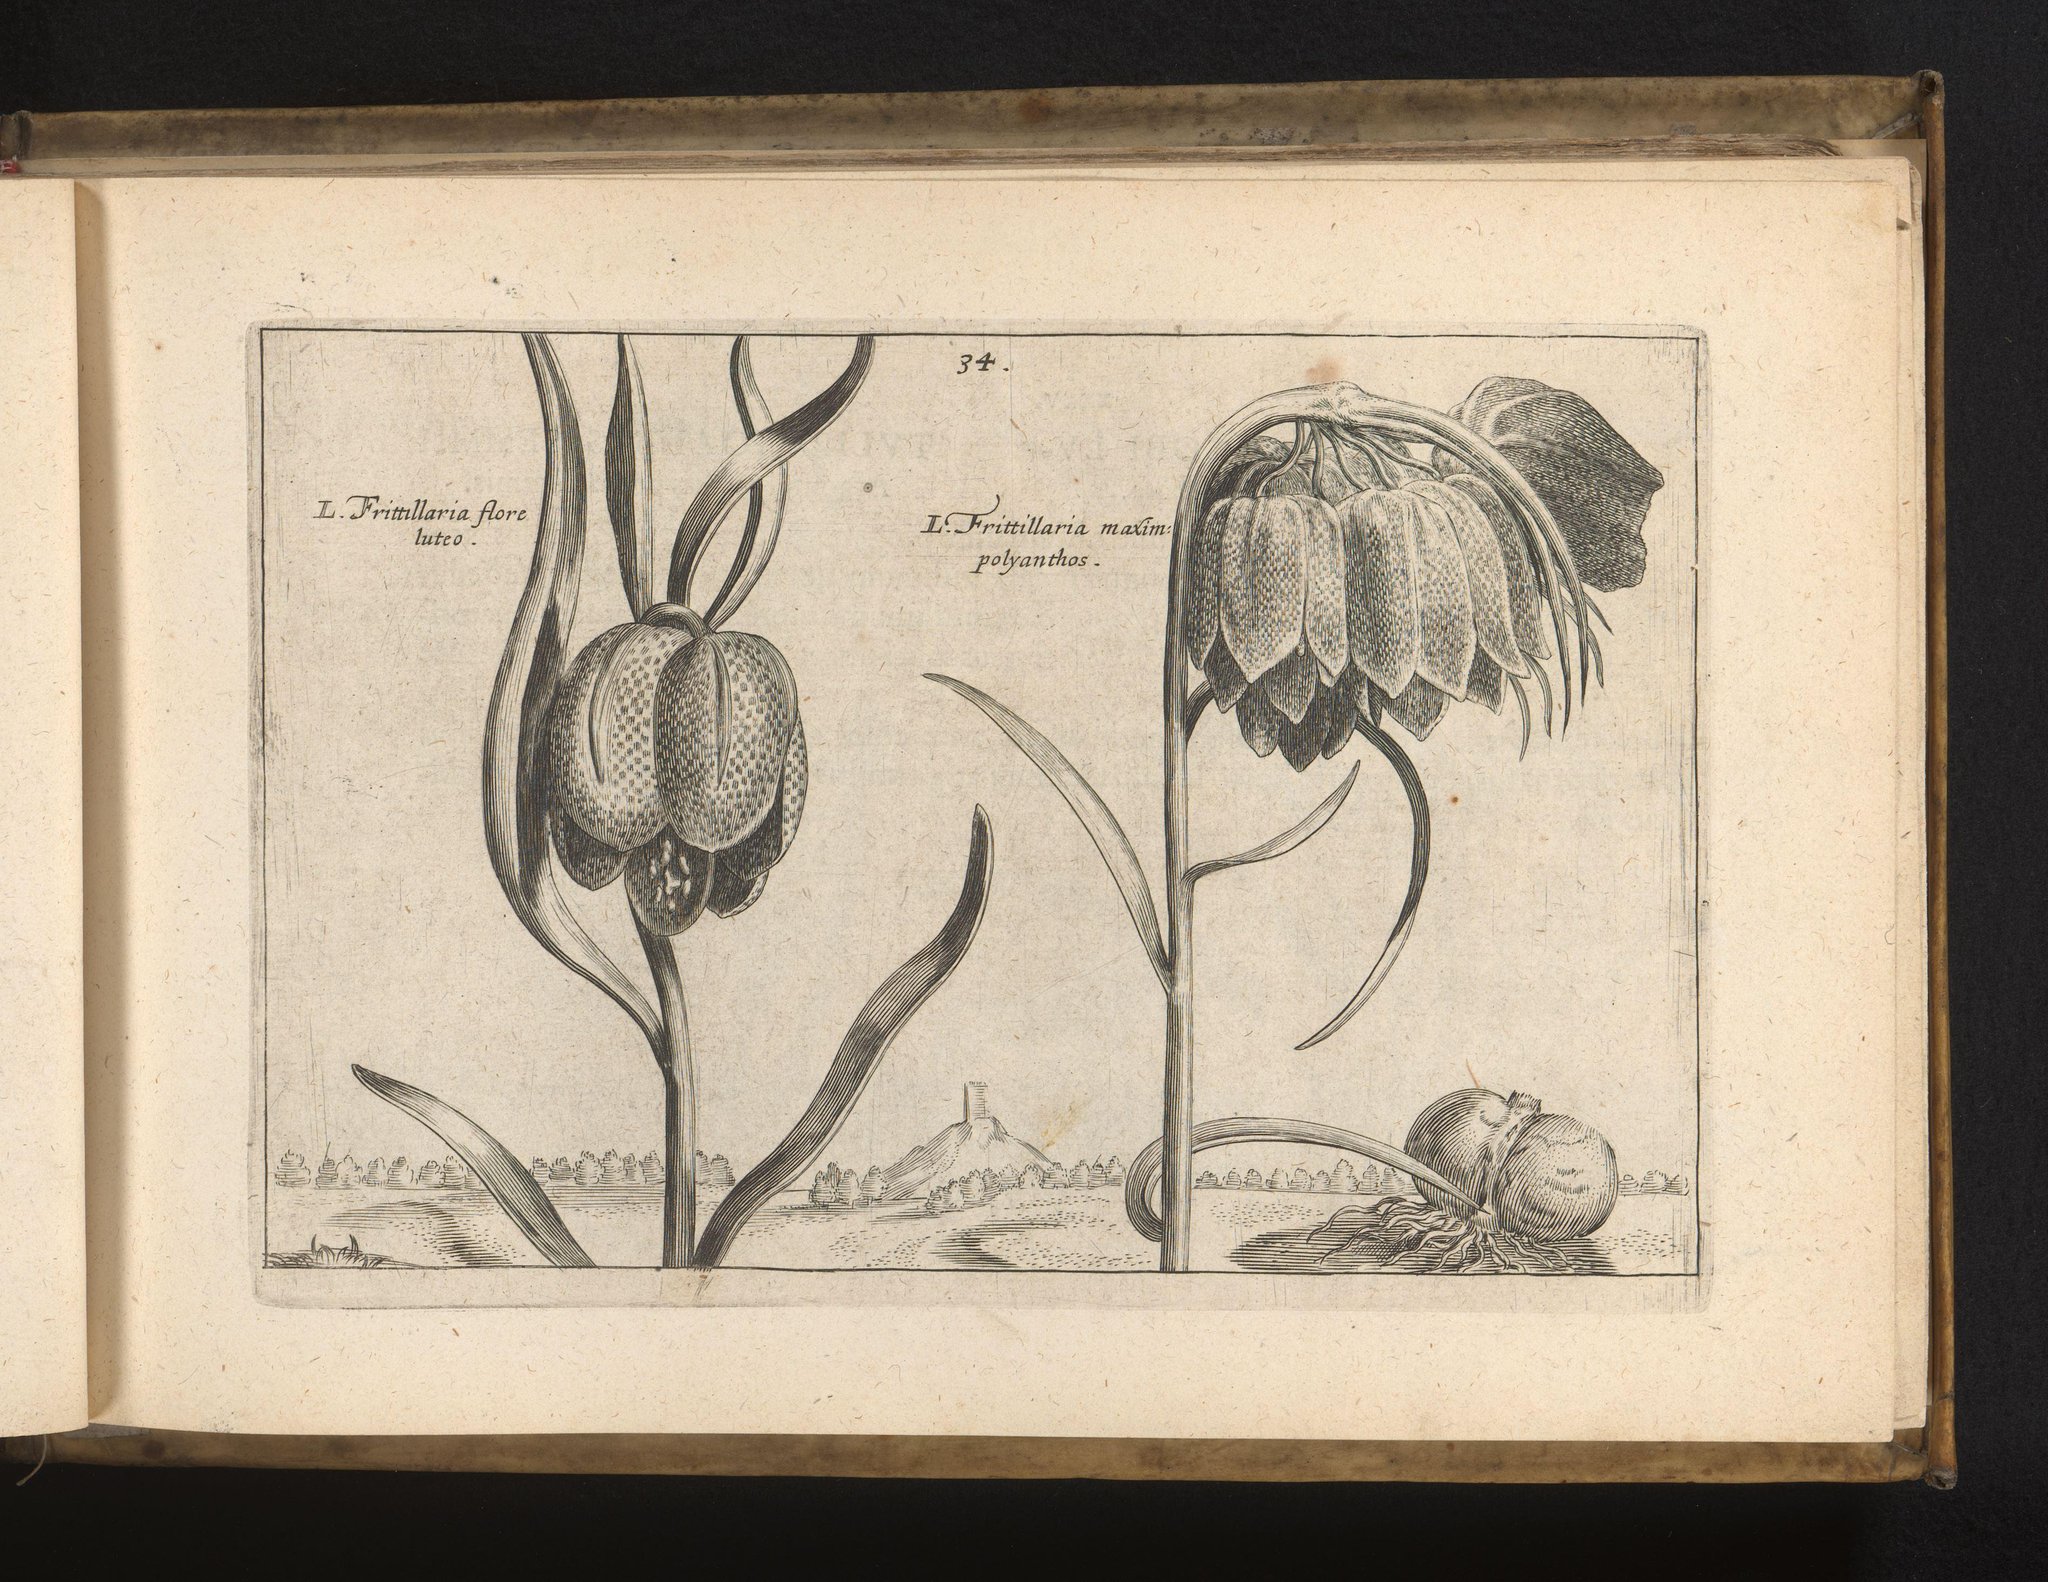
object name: page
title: Twee soorten fritillaria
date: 1617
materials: paper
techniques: engraving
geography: utrecht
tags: flowers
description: Prent uit: Passe, Crispijn van de (II). Hortus floridus in quo rariorum & minus vulgarium florum icones ad vivam veramque formam. Arnhem: Johannes Janssonius, 1617.